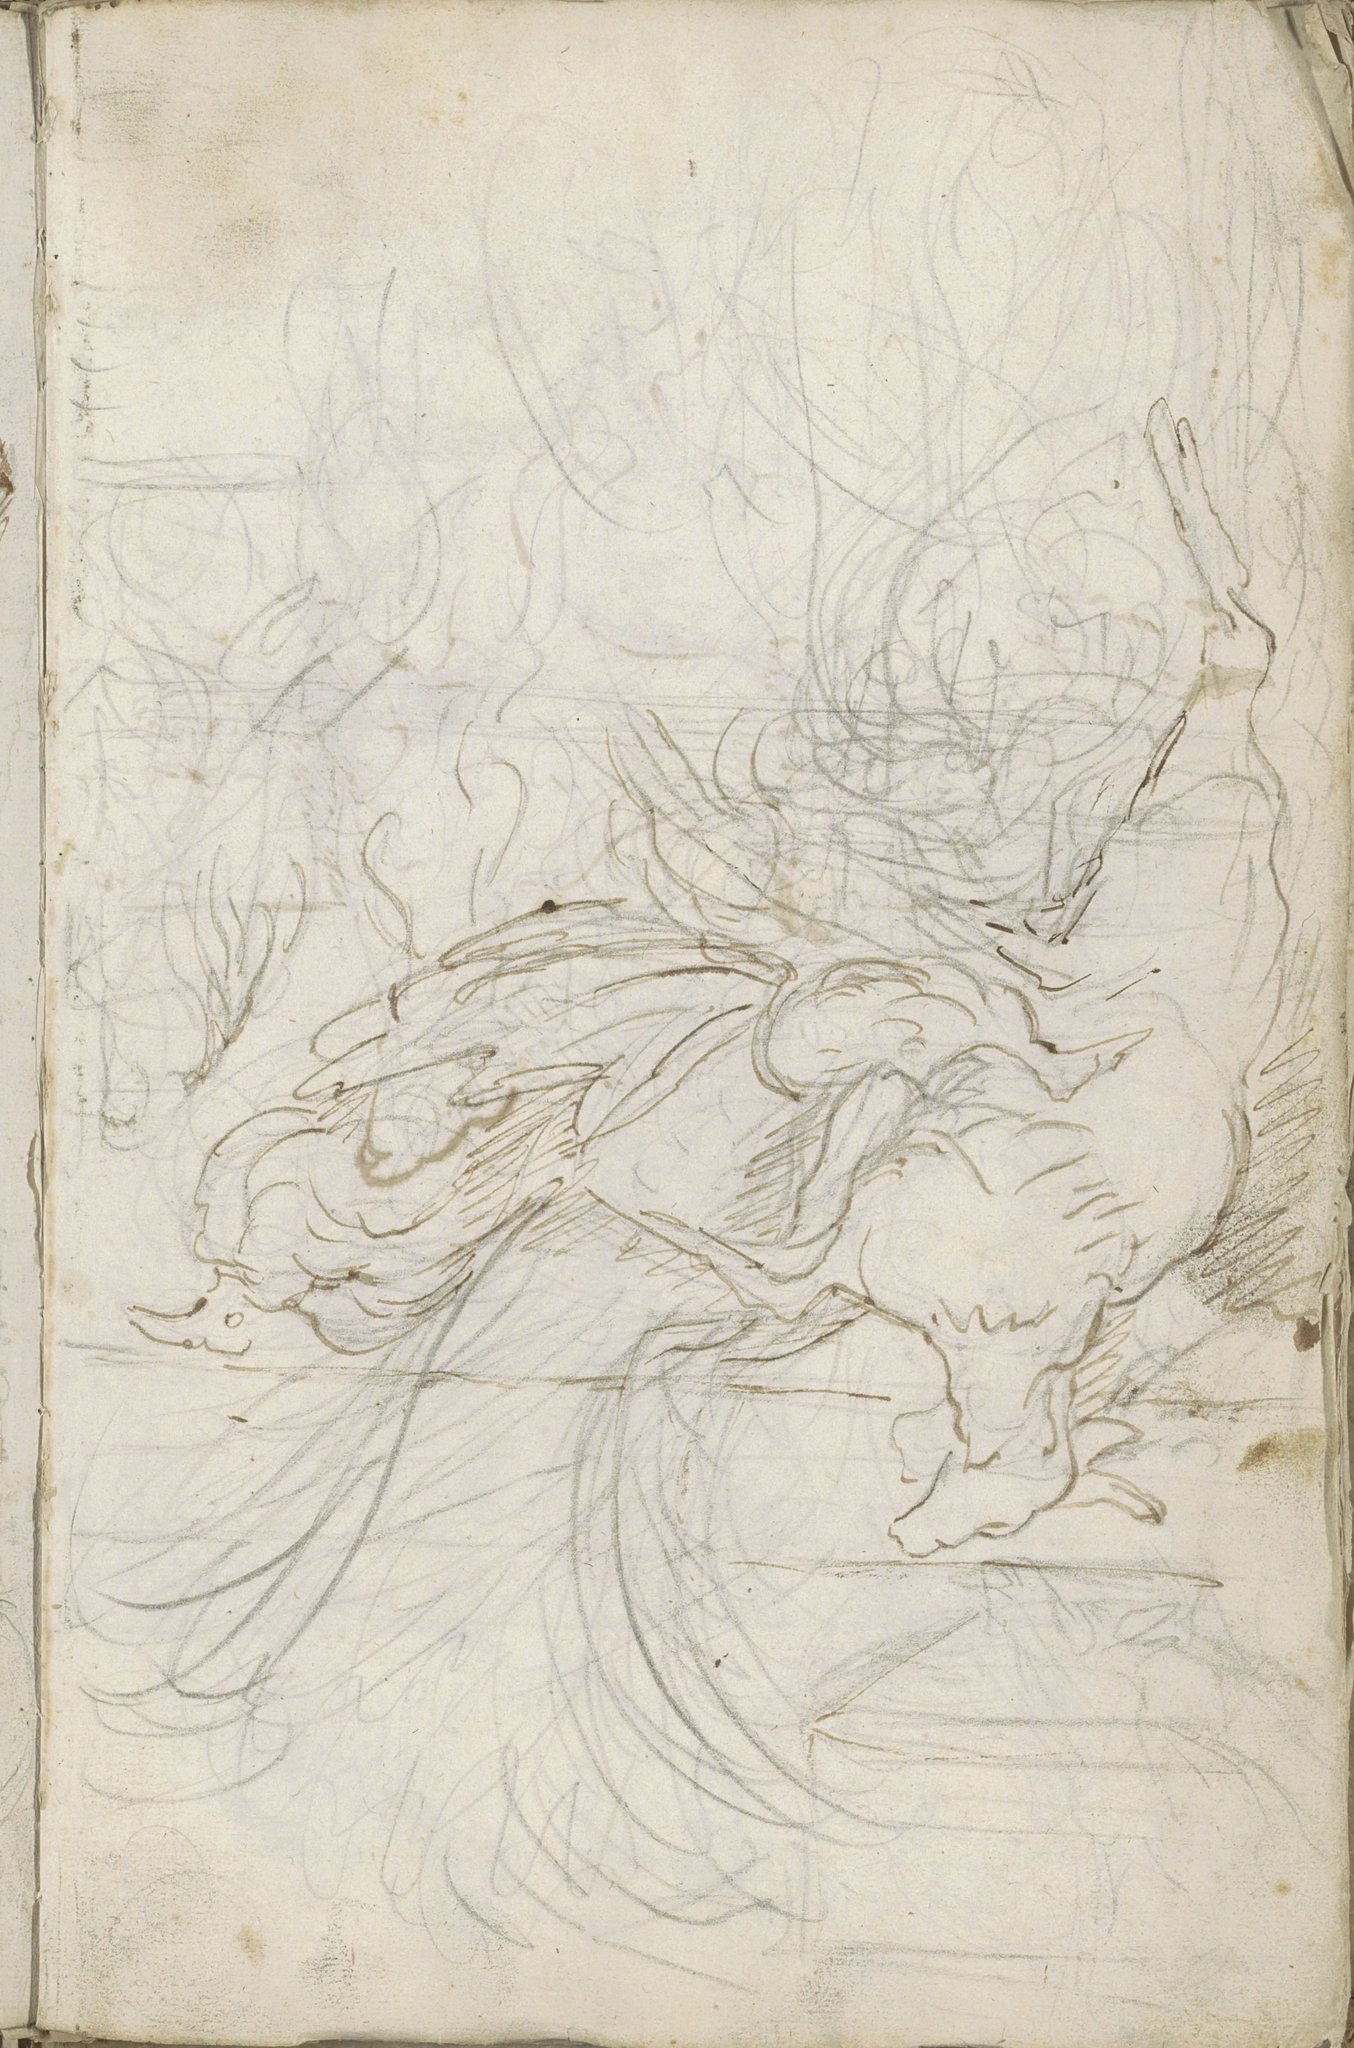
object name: sketchbook leaf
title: Jachtstilleven op een plint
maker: paul de vos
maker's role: draughtsman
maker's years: 1595-1678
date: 1605-1678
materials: ink, paper, pencil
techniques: pen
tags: animals (+ animal killed by man)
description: Blad 10 recto uit een schetsboek met 15 bladen.